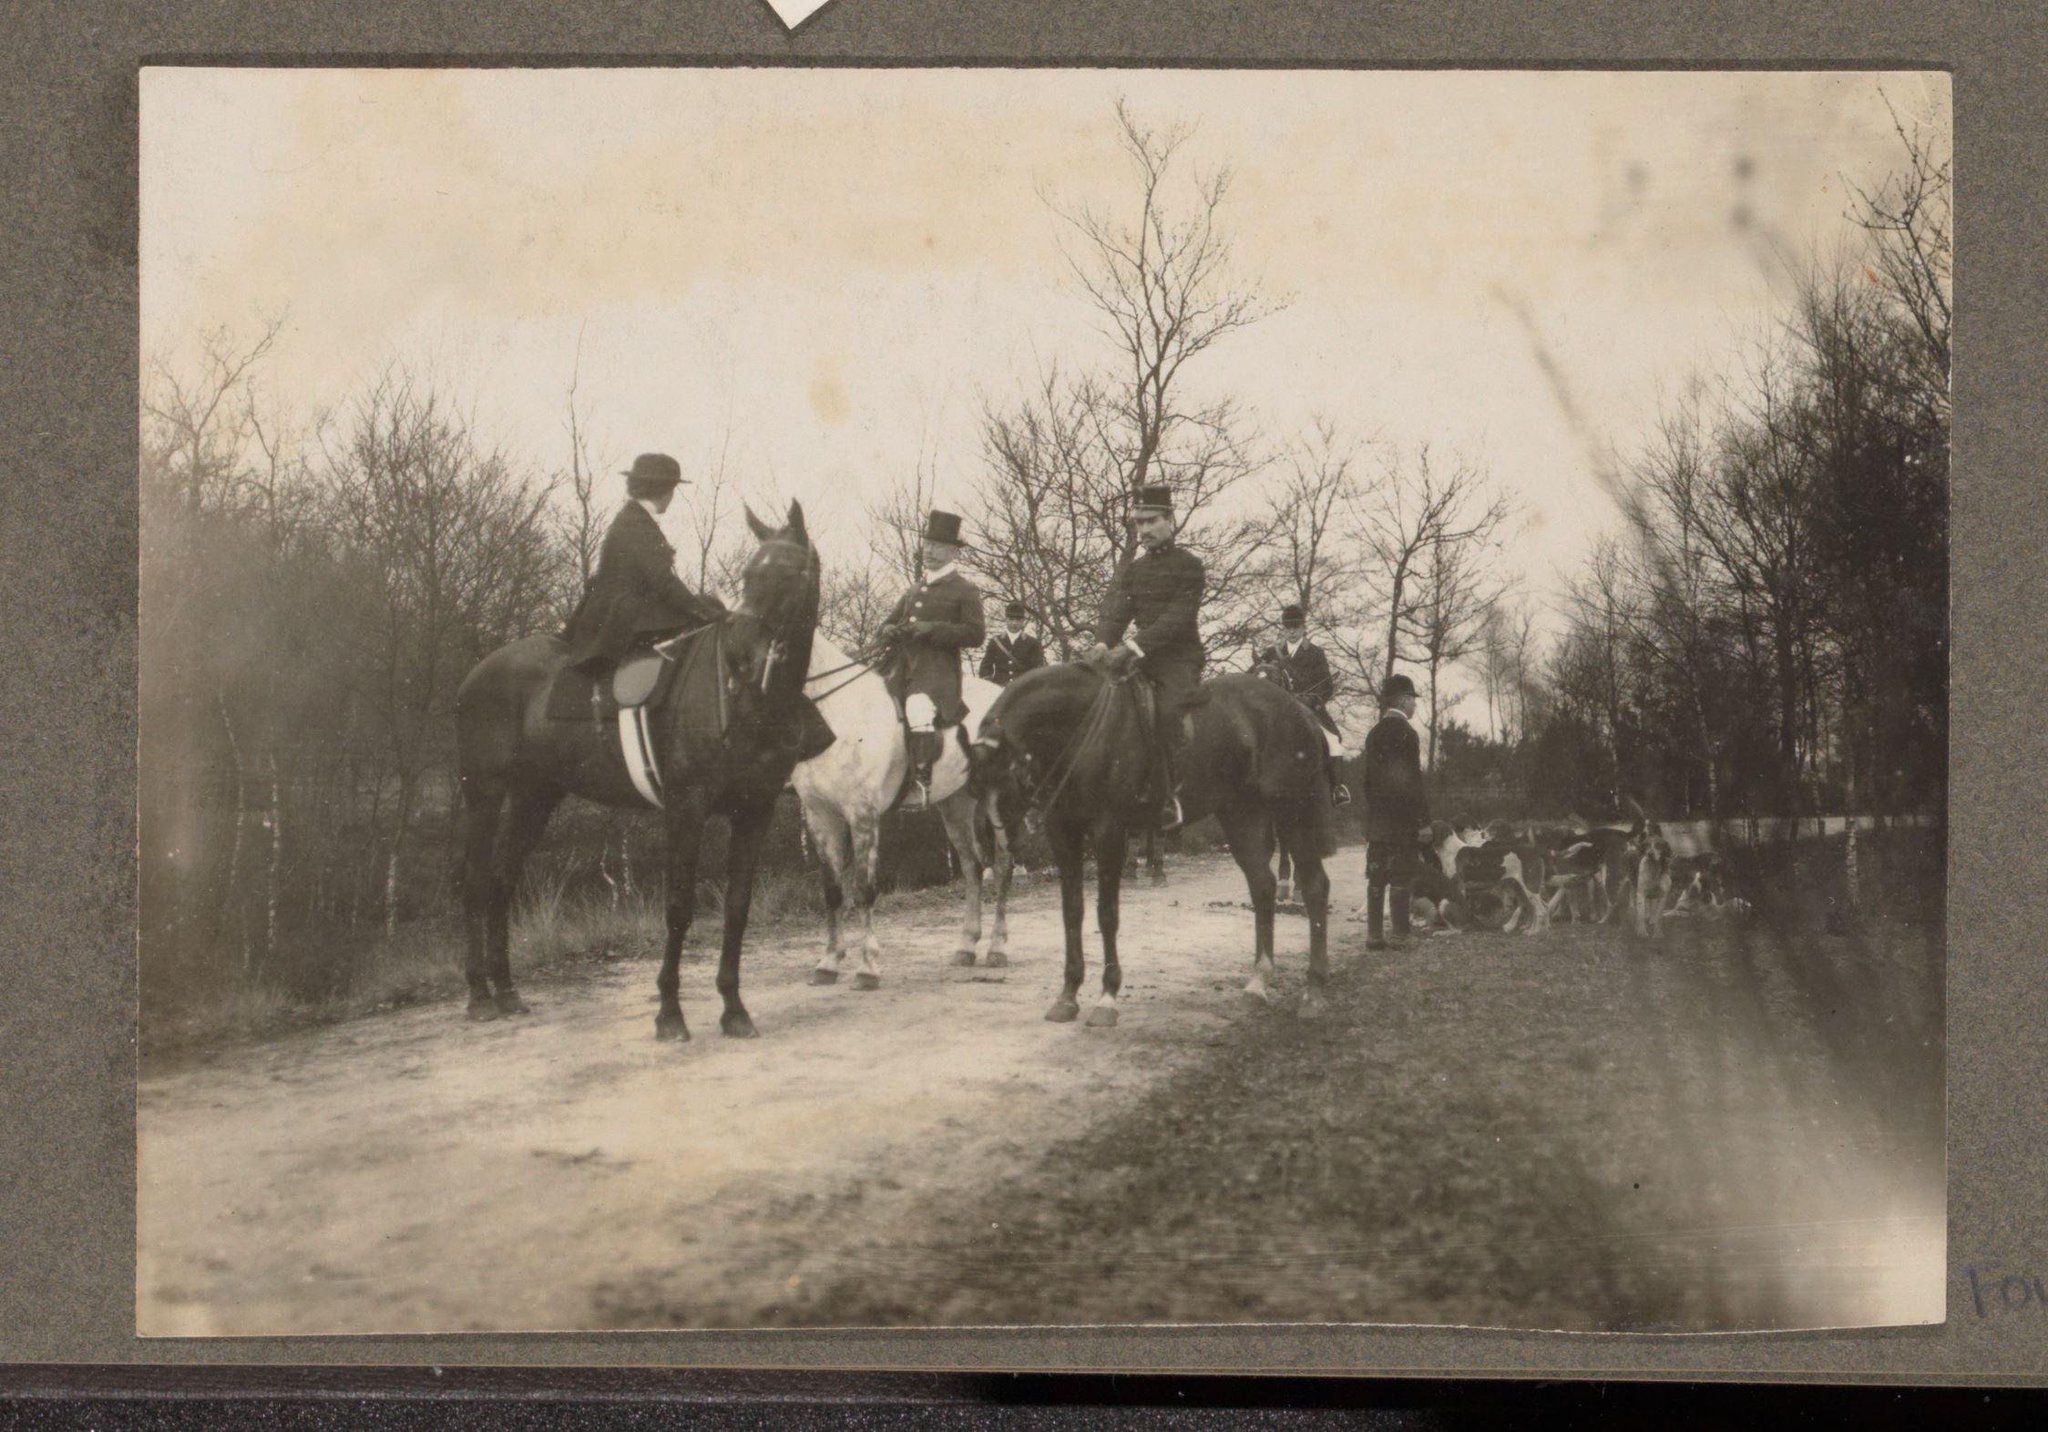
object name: photograph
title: Ruitertafereel op Koninklijke Houtvesterij Het Loo: ruiters met meute honden op een landweg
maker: Anonymous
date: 1900-1925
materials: photographic support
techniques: gelatin silver print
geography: het loo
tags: riding a horse, ass, or mule; rider, horseman, hunting, chase, hunting dogs, hunting-ground, forest path or lane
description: Onderdeel van Fotoalbum van de heer Brams, opperhoutvester van koningin Wilhelmina op Koninklijke Houtvesterij Het Loo.